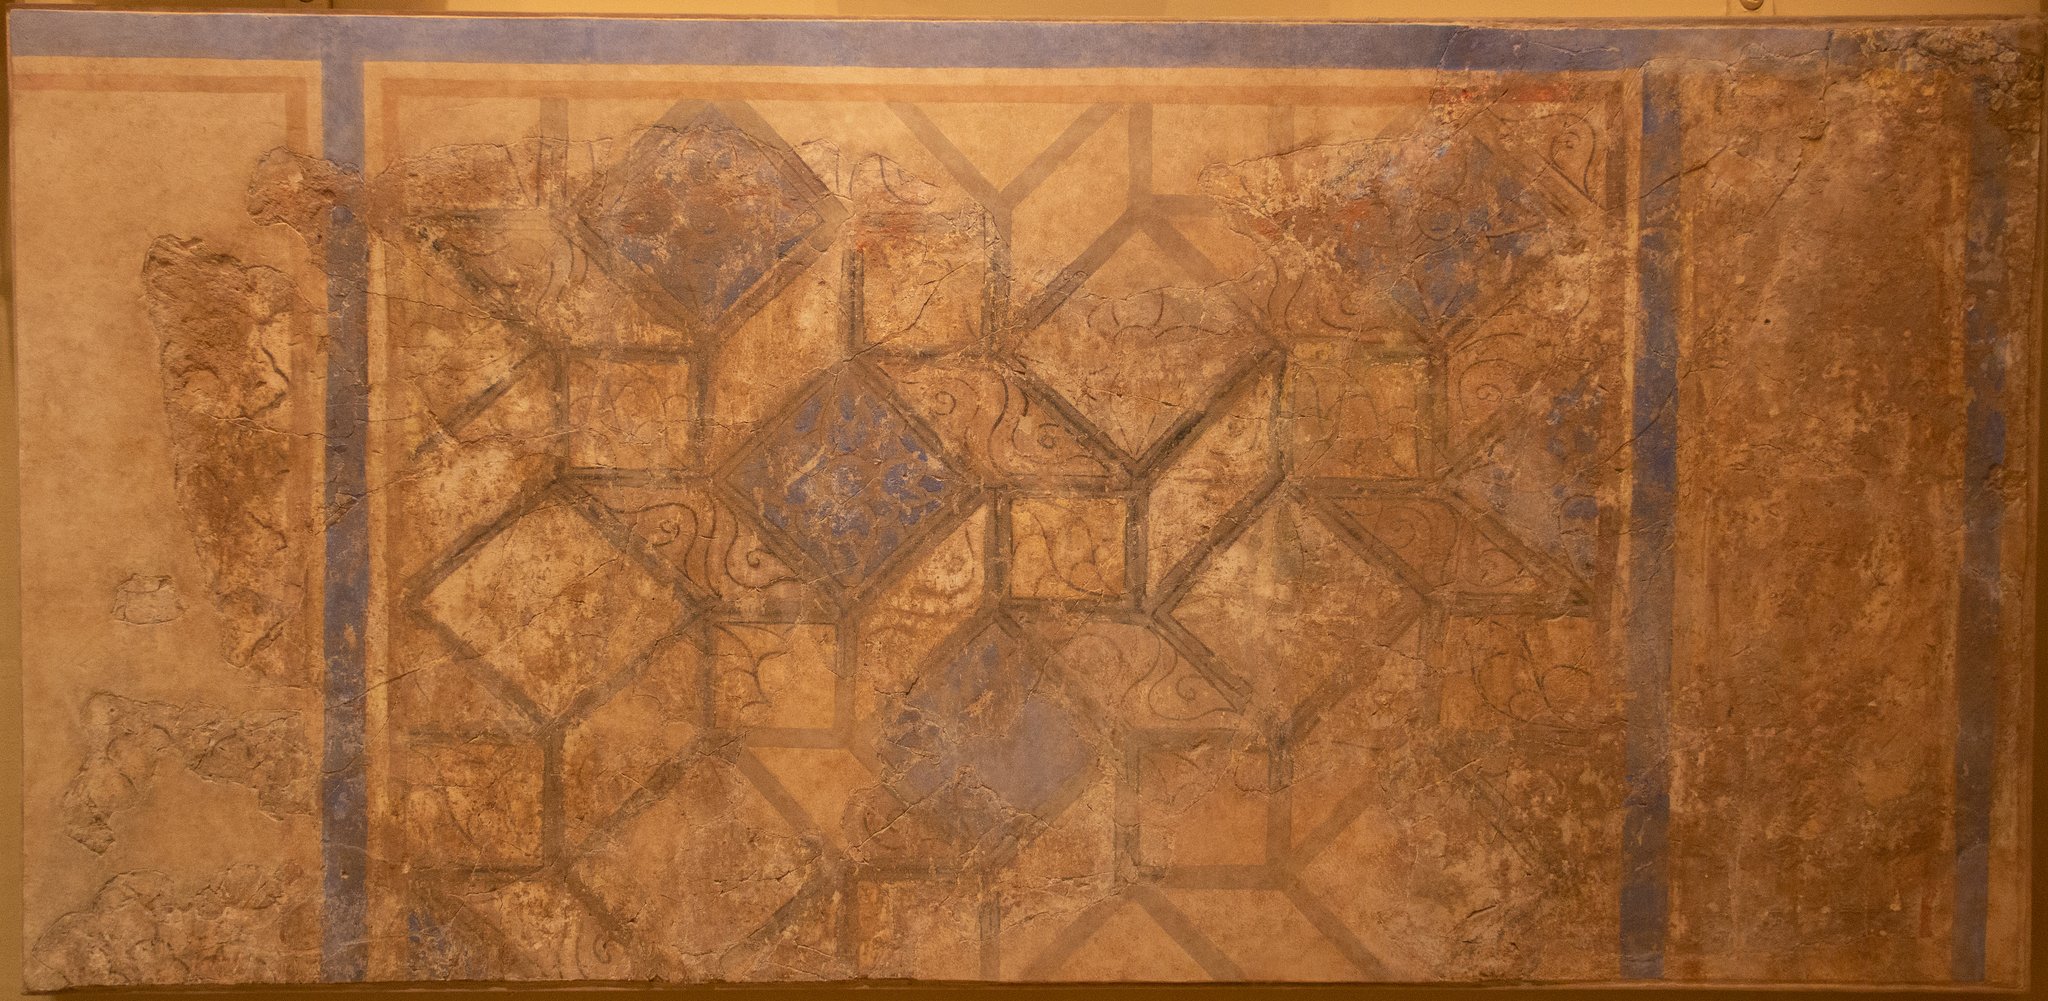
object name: wall painting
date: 801-900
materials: plaster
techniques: painting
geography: iran